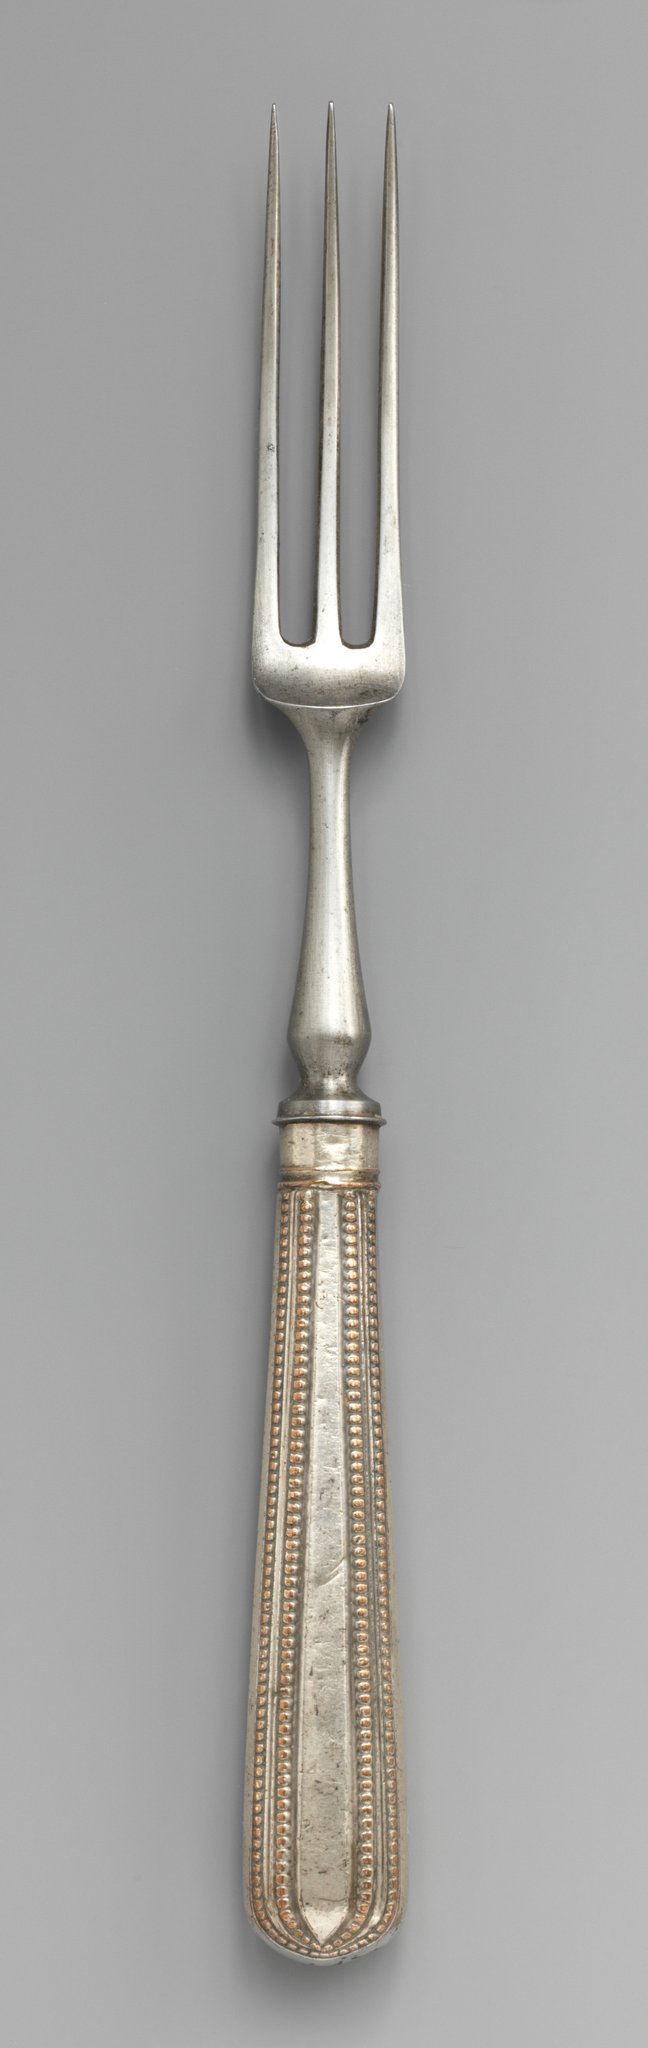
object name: fork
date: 1780-1790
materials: metal